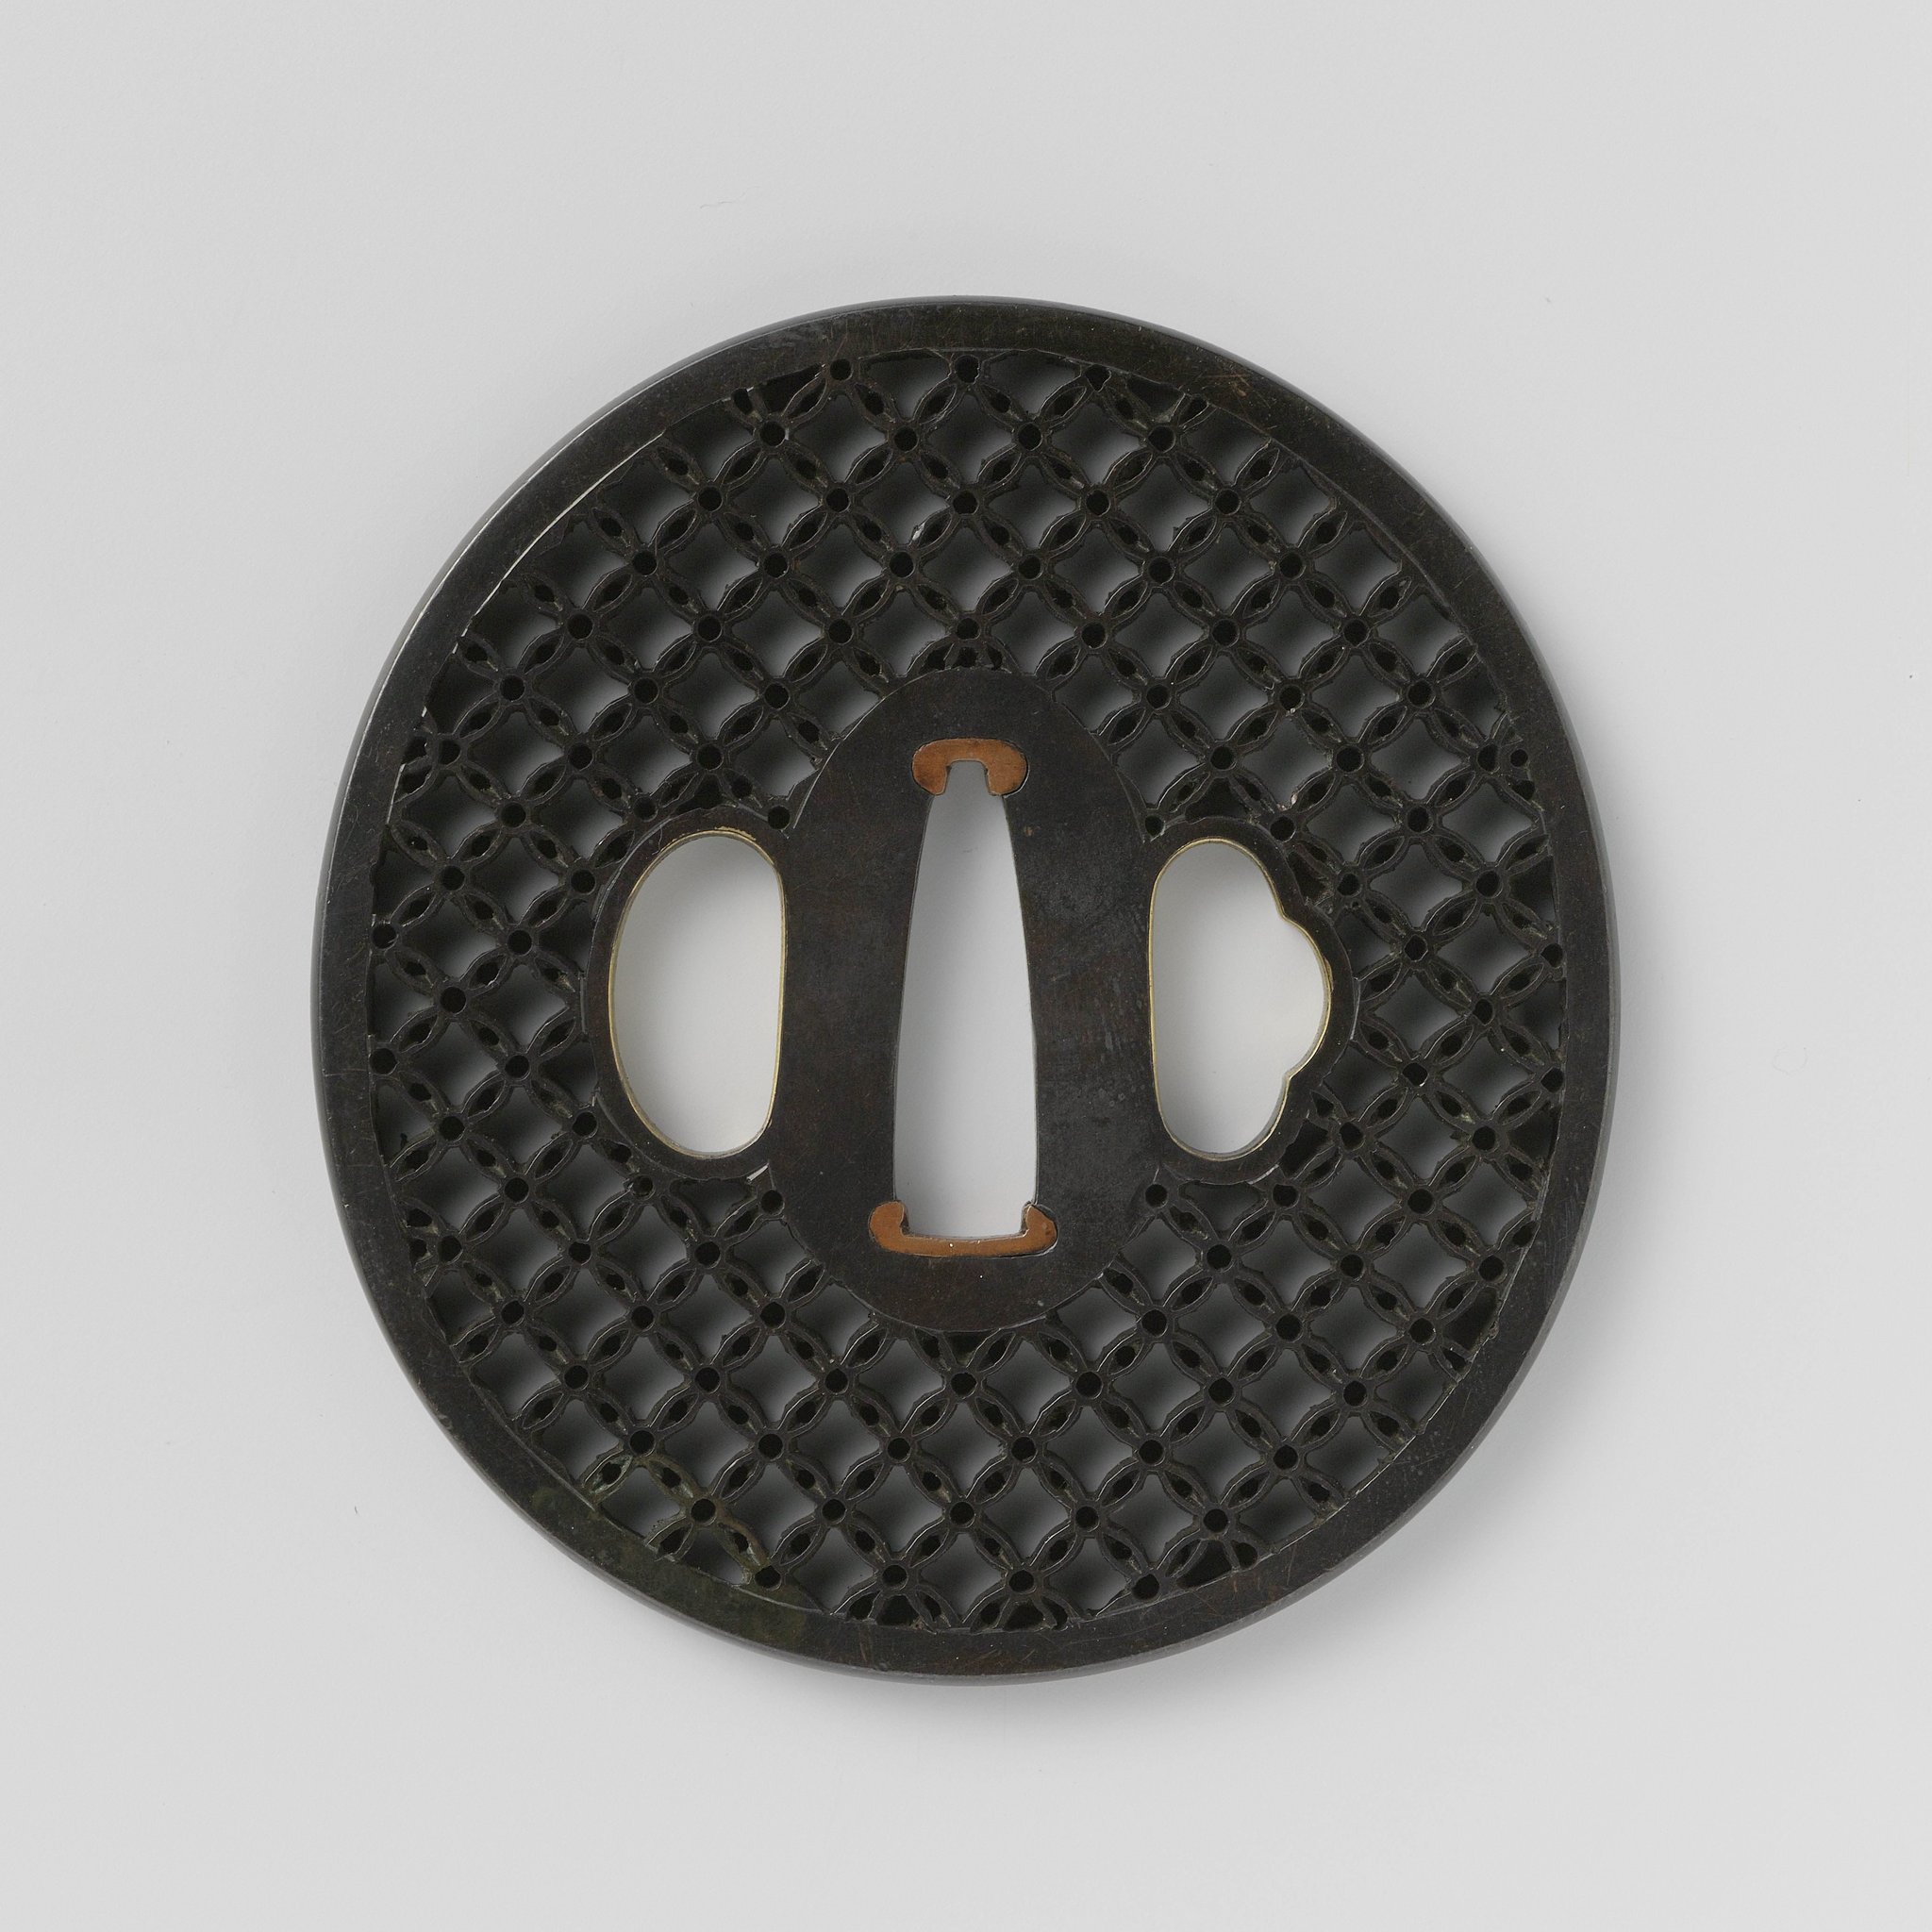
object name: tsuba, zwaardstootplaat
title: Hand guard with circle motif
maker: Anonymous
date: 1750-1850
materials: gold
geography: japan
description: Ovale tsuba met opengewerkte decoratie in ito sukashi van de zogenaamde "eindeloze cirkels van de zeven schatten" (shippo tsunagi); binnenzijde van de ryo-hitsu bekleed met goud.